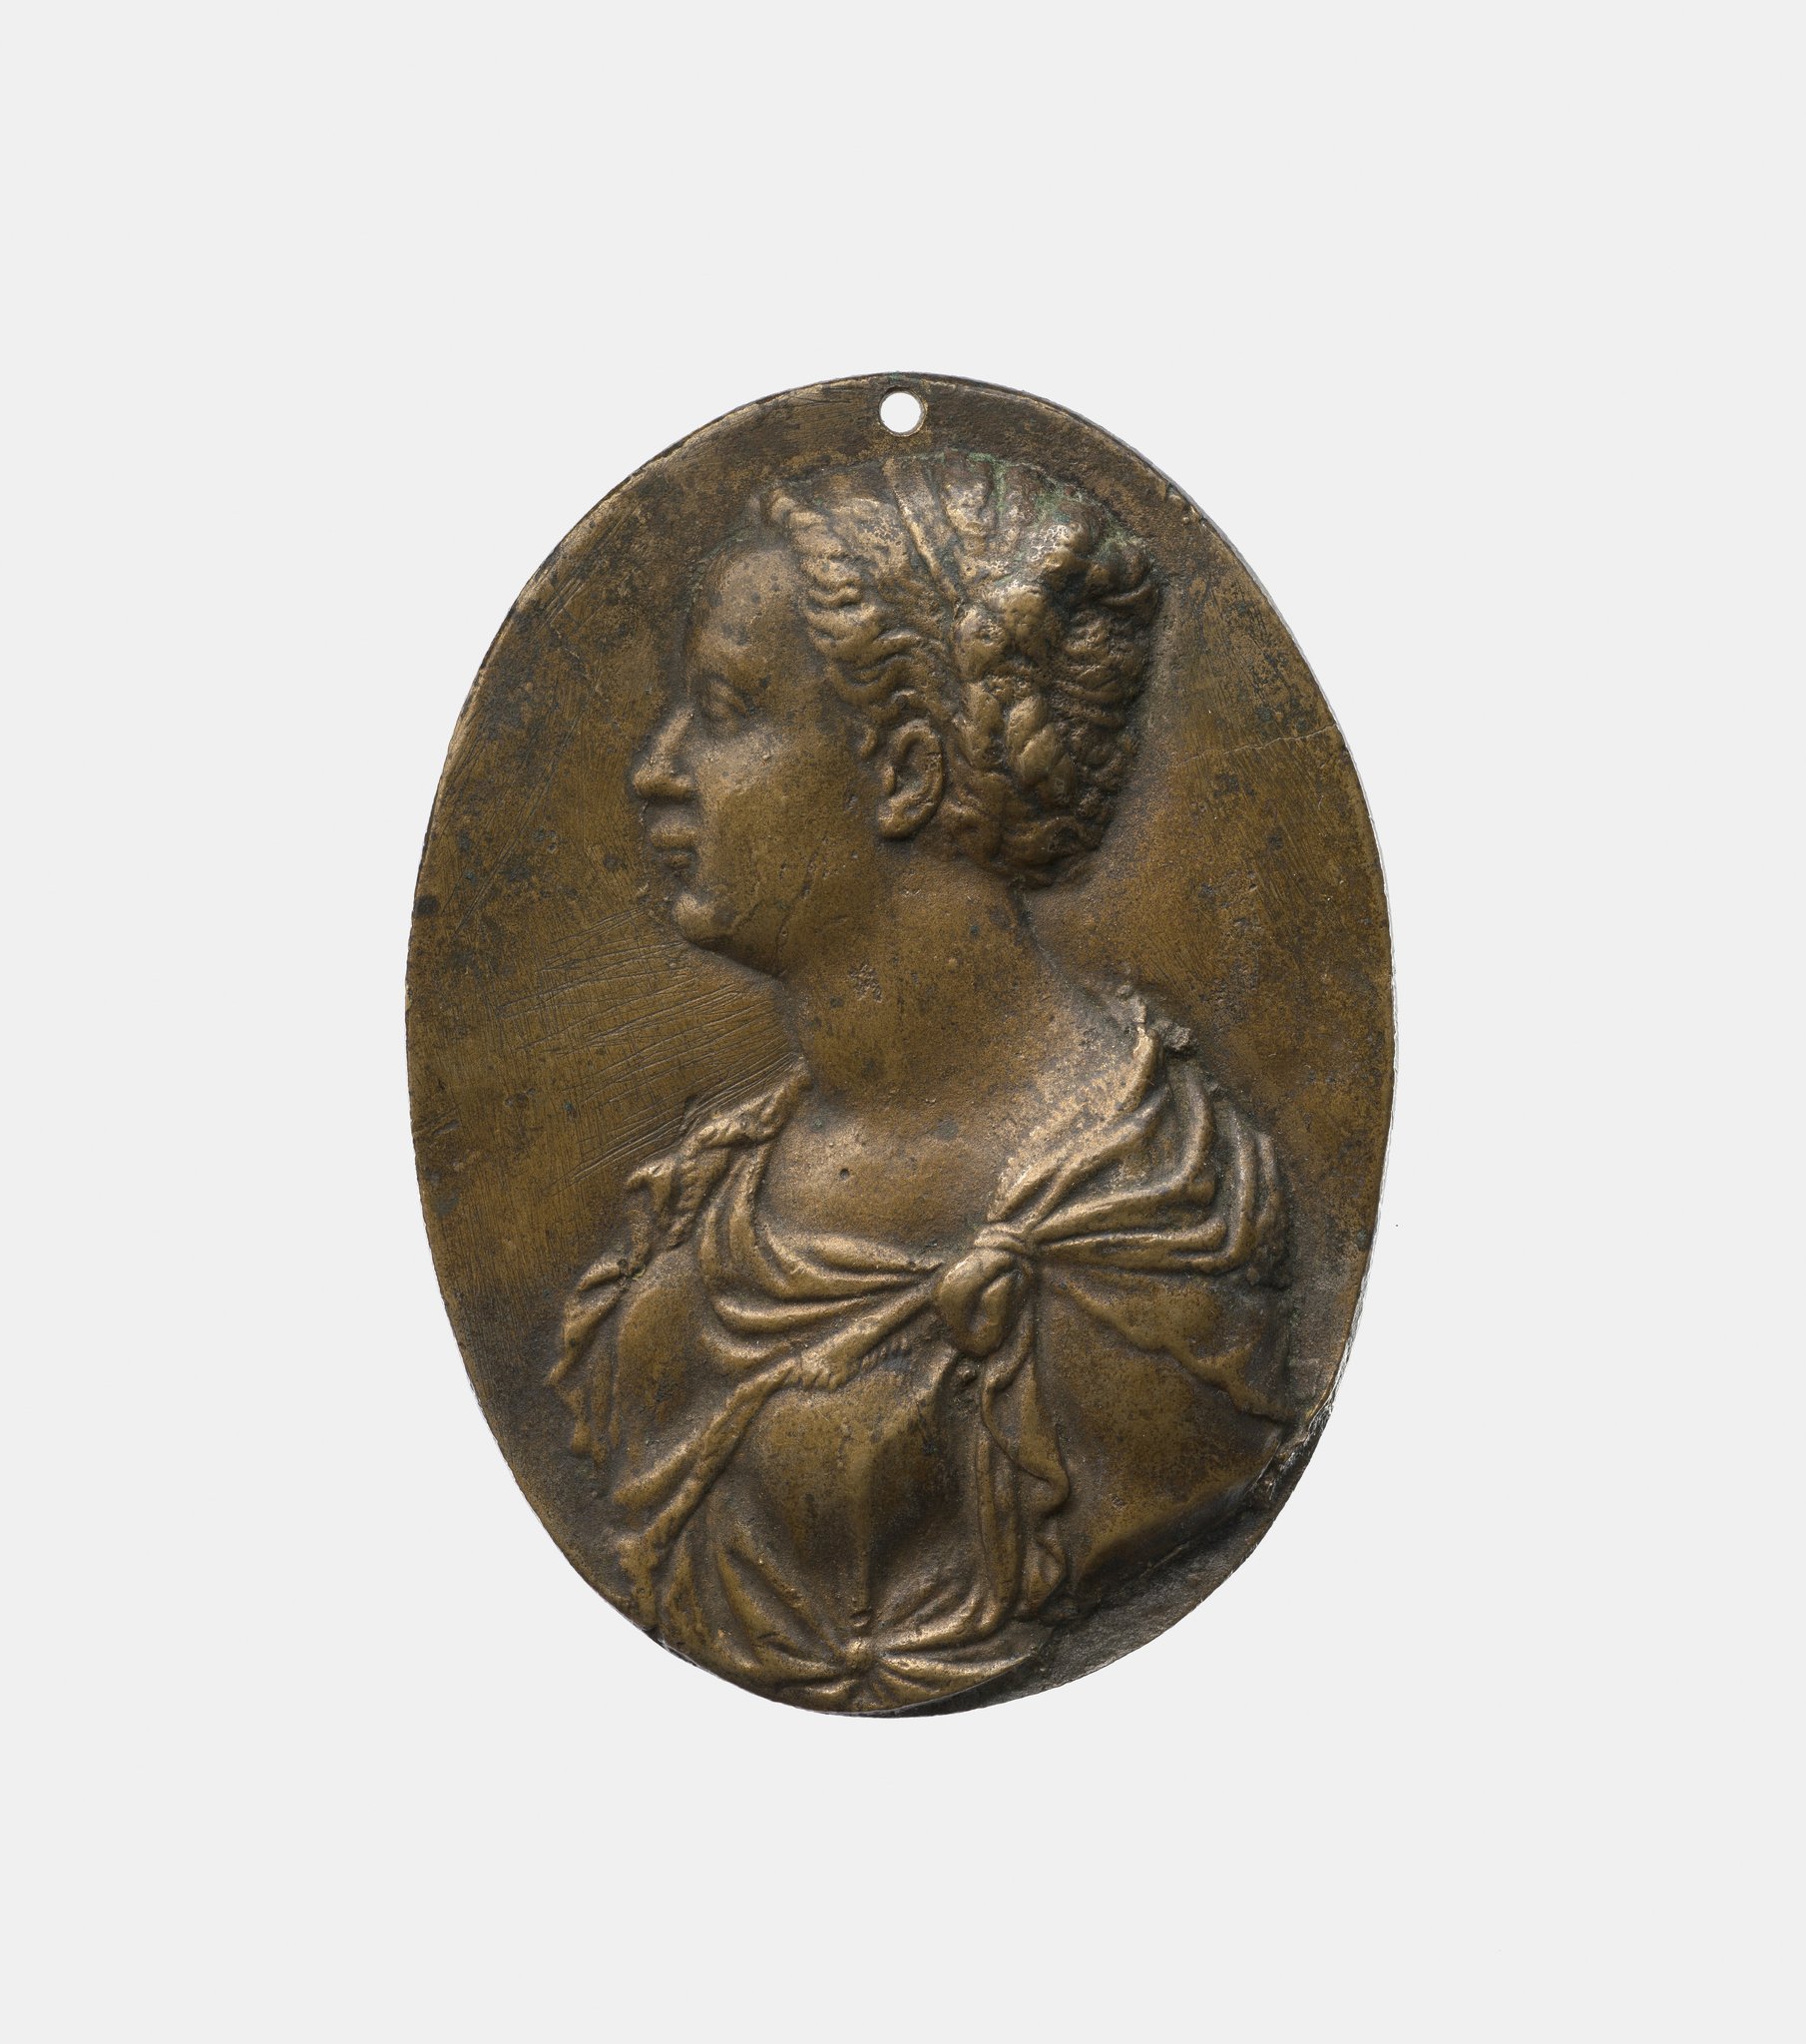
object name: plaquette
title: Unknown young lady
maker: alfonso ruspagiari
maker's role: artist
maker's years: 1521-1576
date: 1521-1576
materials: bronze